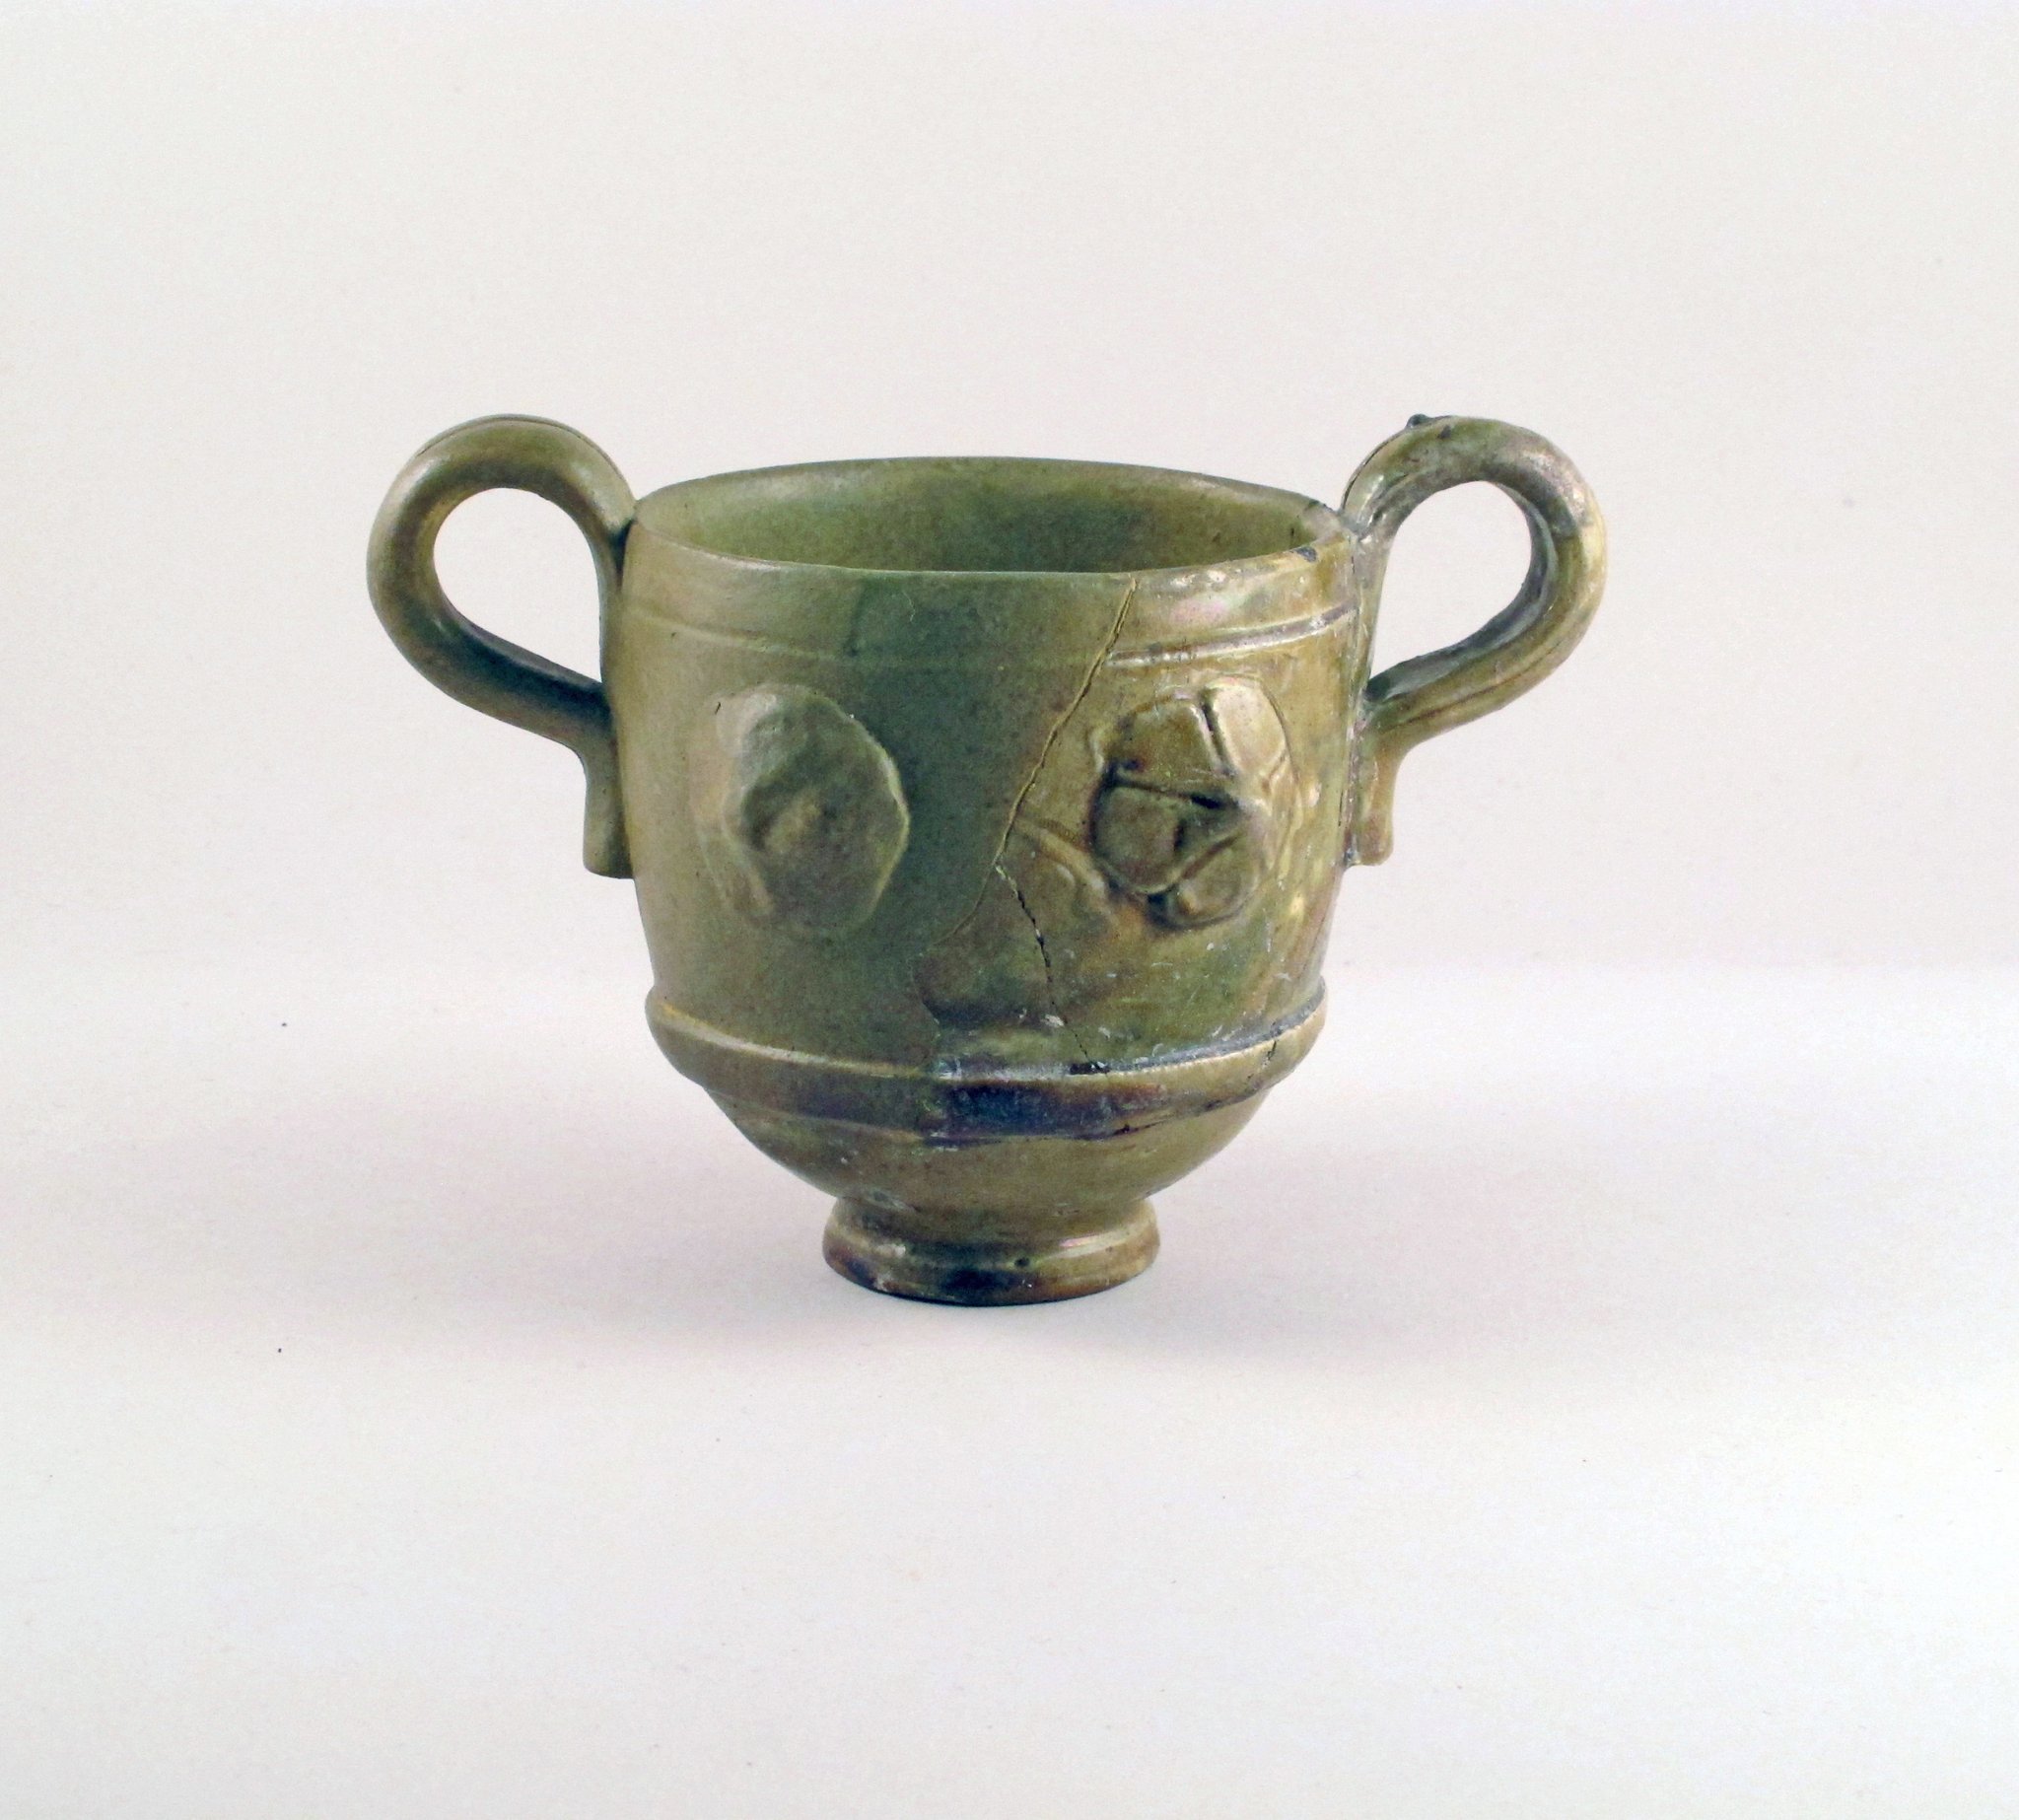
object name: vase fragment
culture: roman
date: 670 BCE-330 CE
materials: terracotta